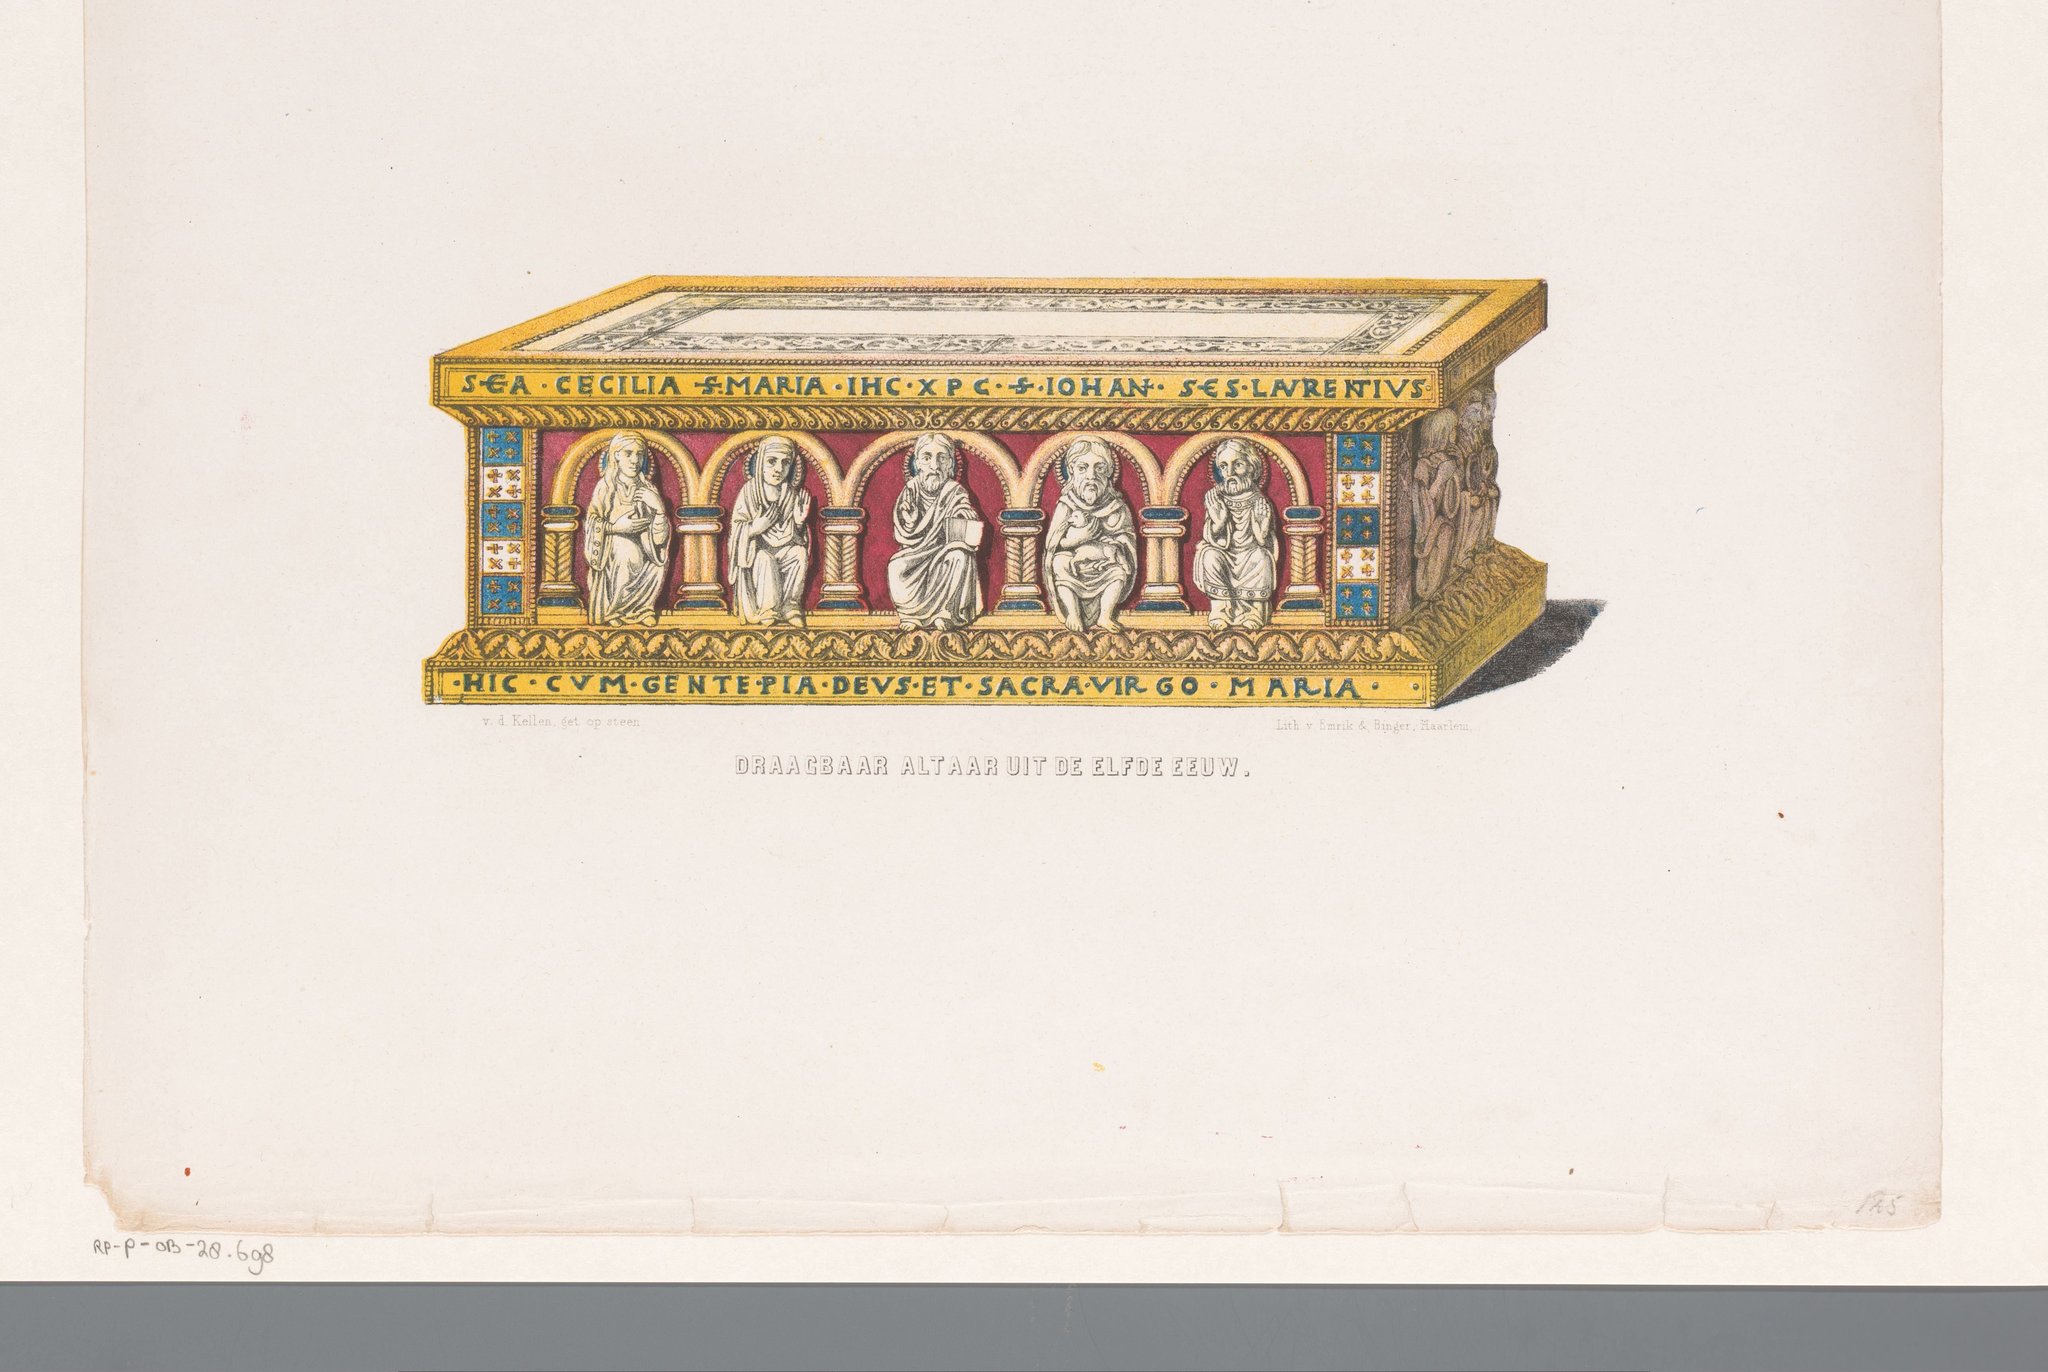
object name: historical object representation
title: Draagbaar altaar uit de elfde eeuw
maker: david van der kellen (1827-1895)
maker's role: draughtsman, print maker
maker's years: 1827-1895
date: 1857-1864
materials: paper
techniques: tone lithography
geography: haarlem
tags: portable altar, netherlands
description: Illustratie voor: W.J. Hofdijk, Ons voorgeslacht in zijn dagelyksch leven geschilderd, Kruseman, Haarlem 1859-1864.